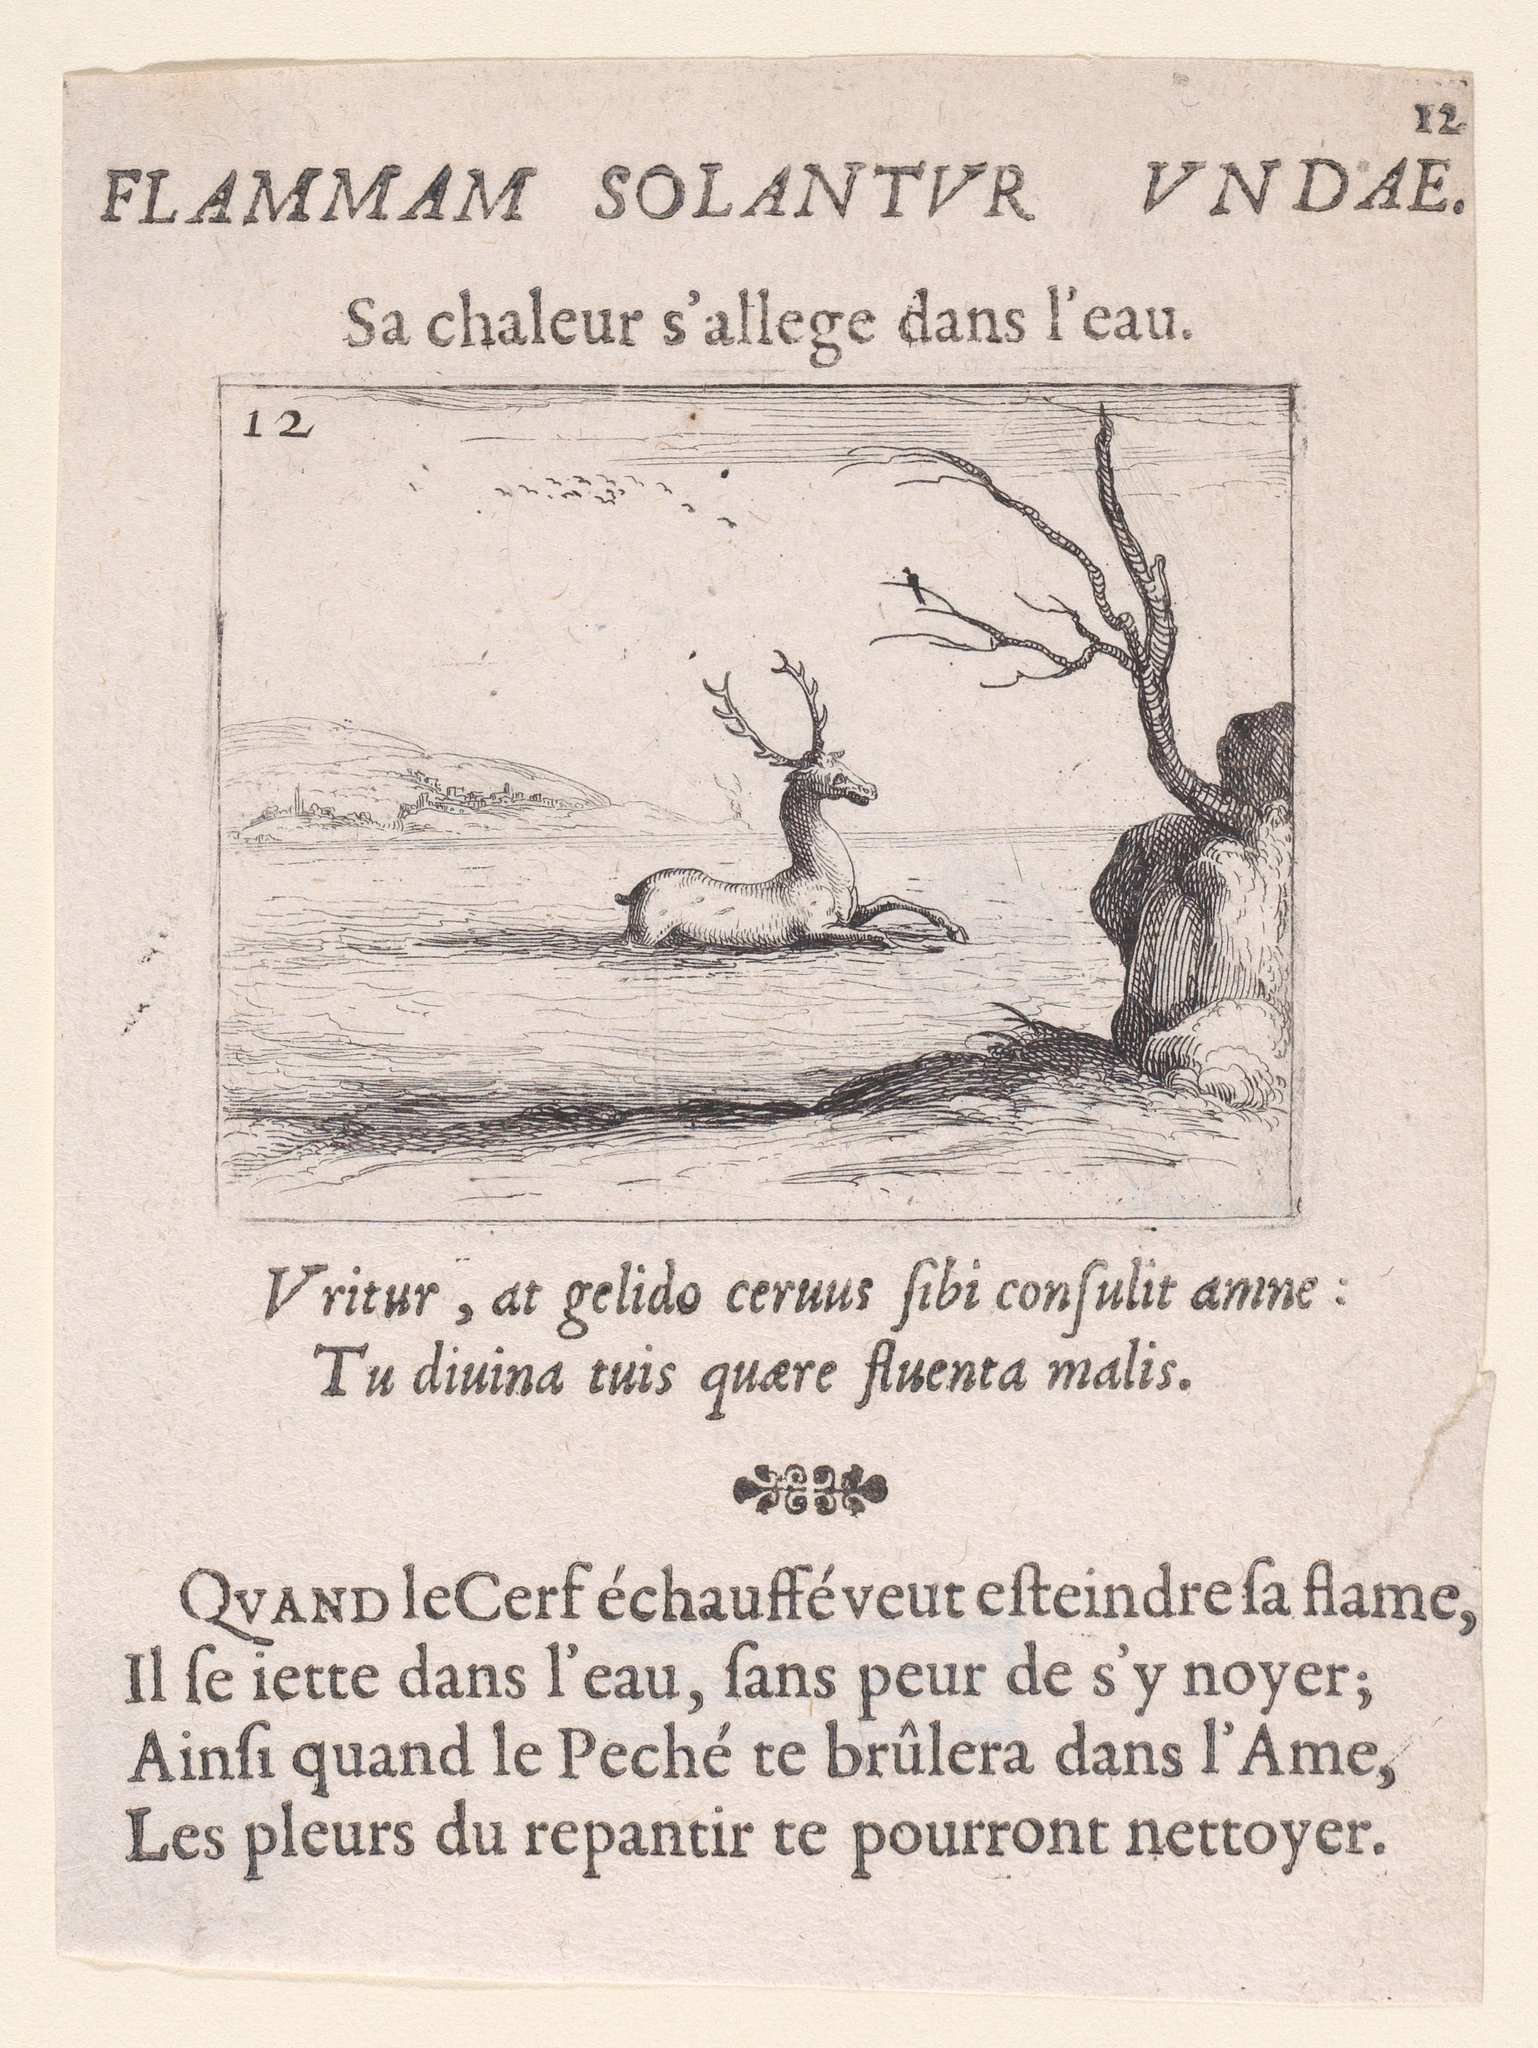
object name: print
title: Un Cerf dans l'Eau (A Deer in the Water), plate 12 from "Lux Claustri ou La Lumière du Cloitre" (The Light of the Cloisters)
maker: jacques callot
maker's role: artist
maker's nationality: french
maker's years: 1592-1635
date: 1625-1631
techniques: etching, letterpress